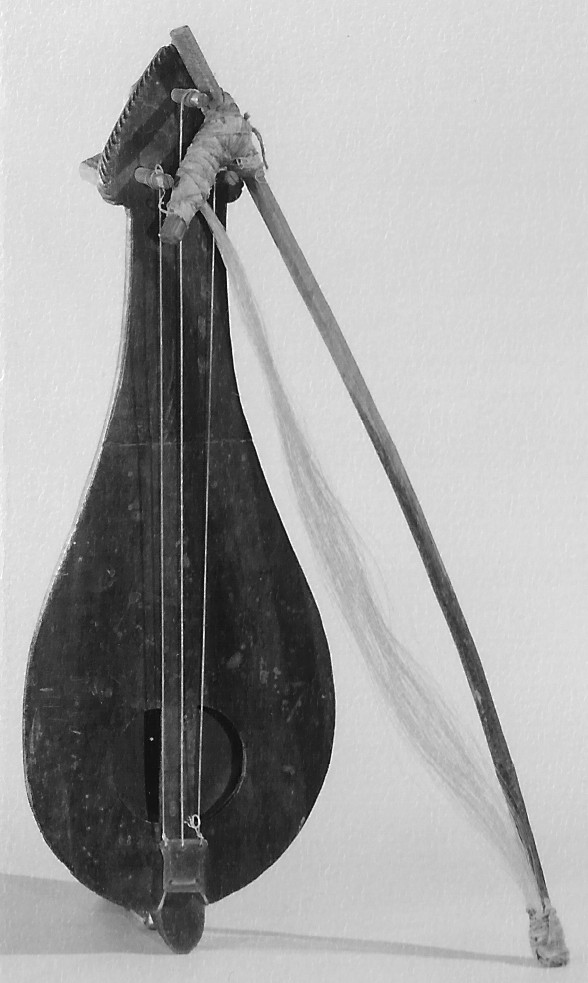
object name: lijerica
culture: croatian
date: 1834-1866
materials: wood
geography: croatia